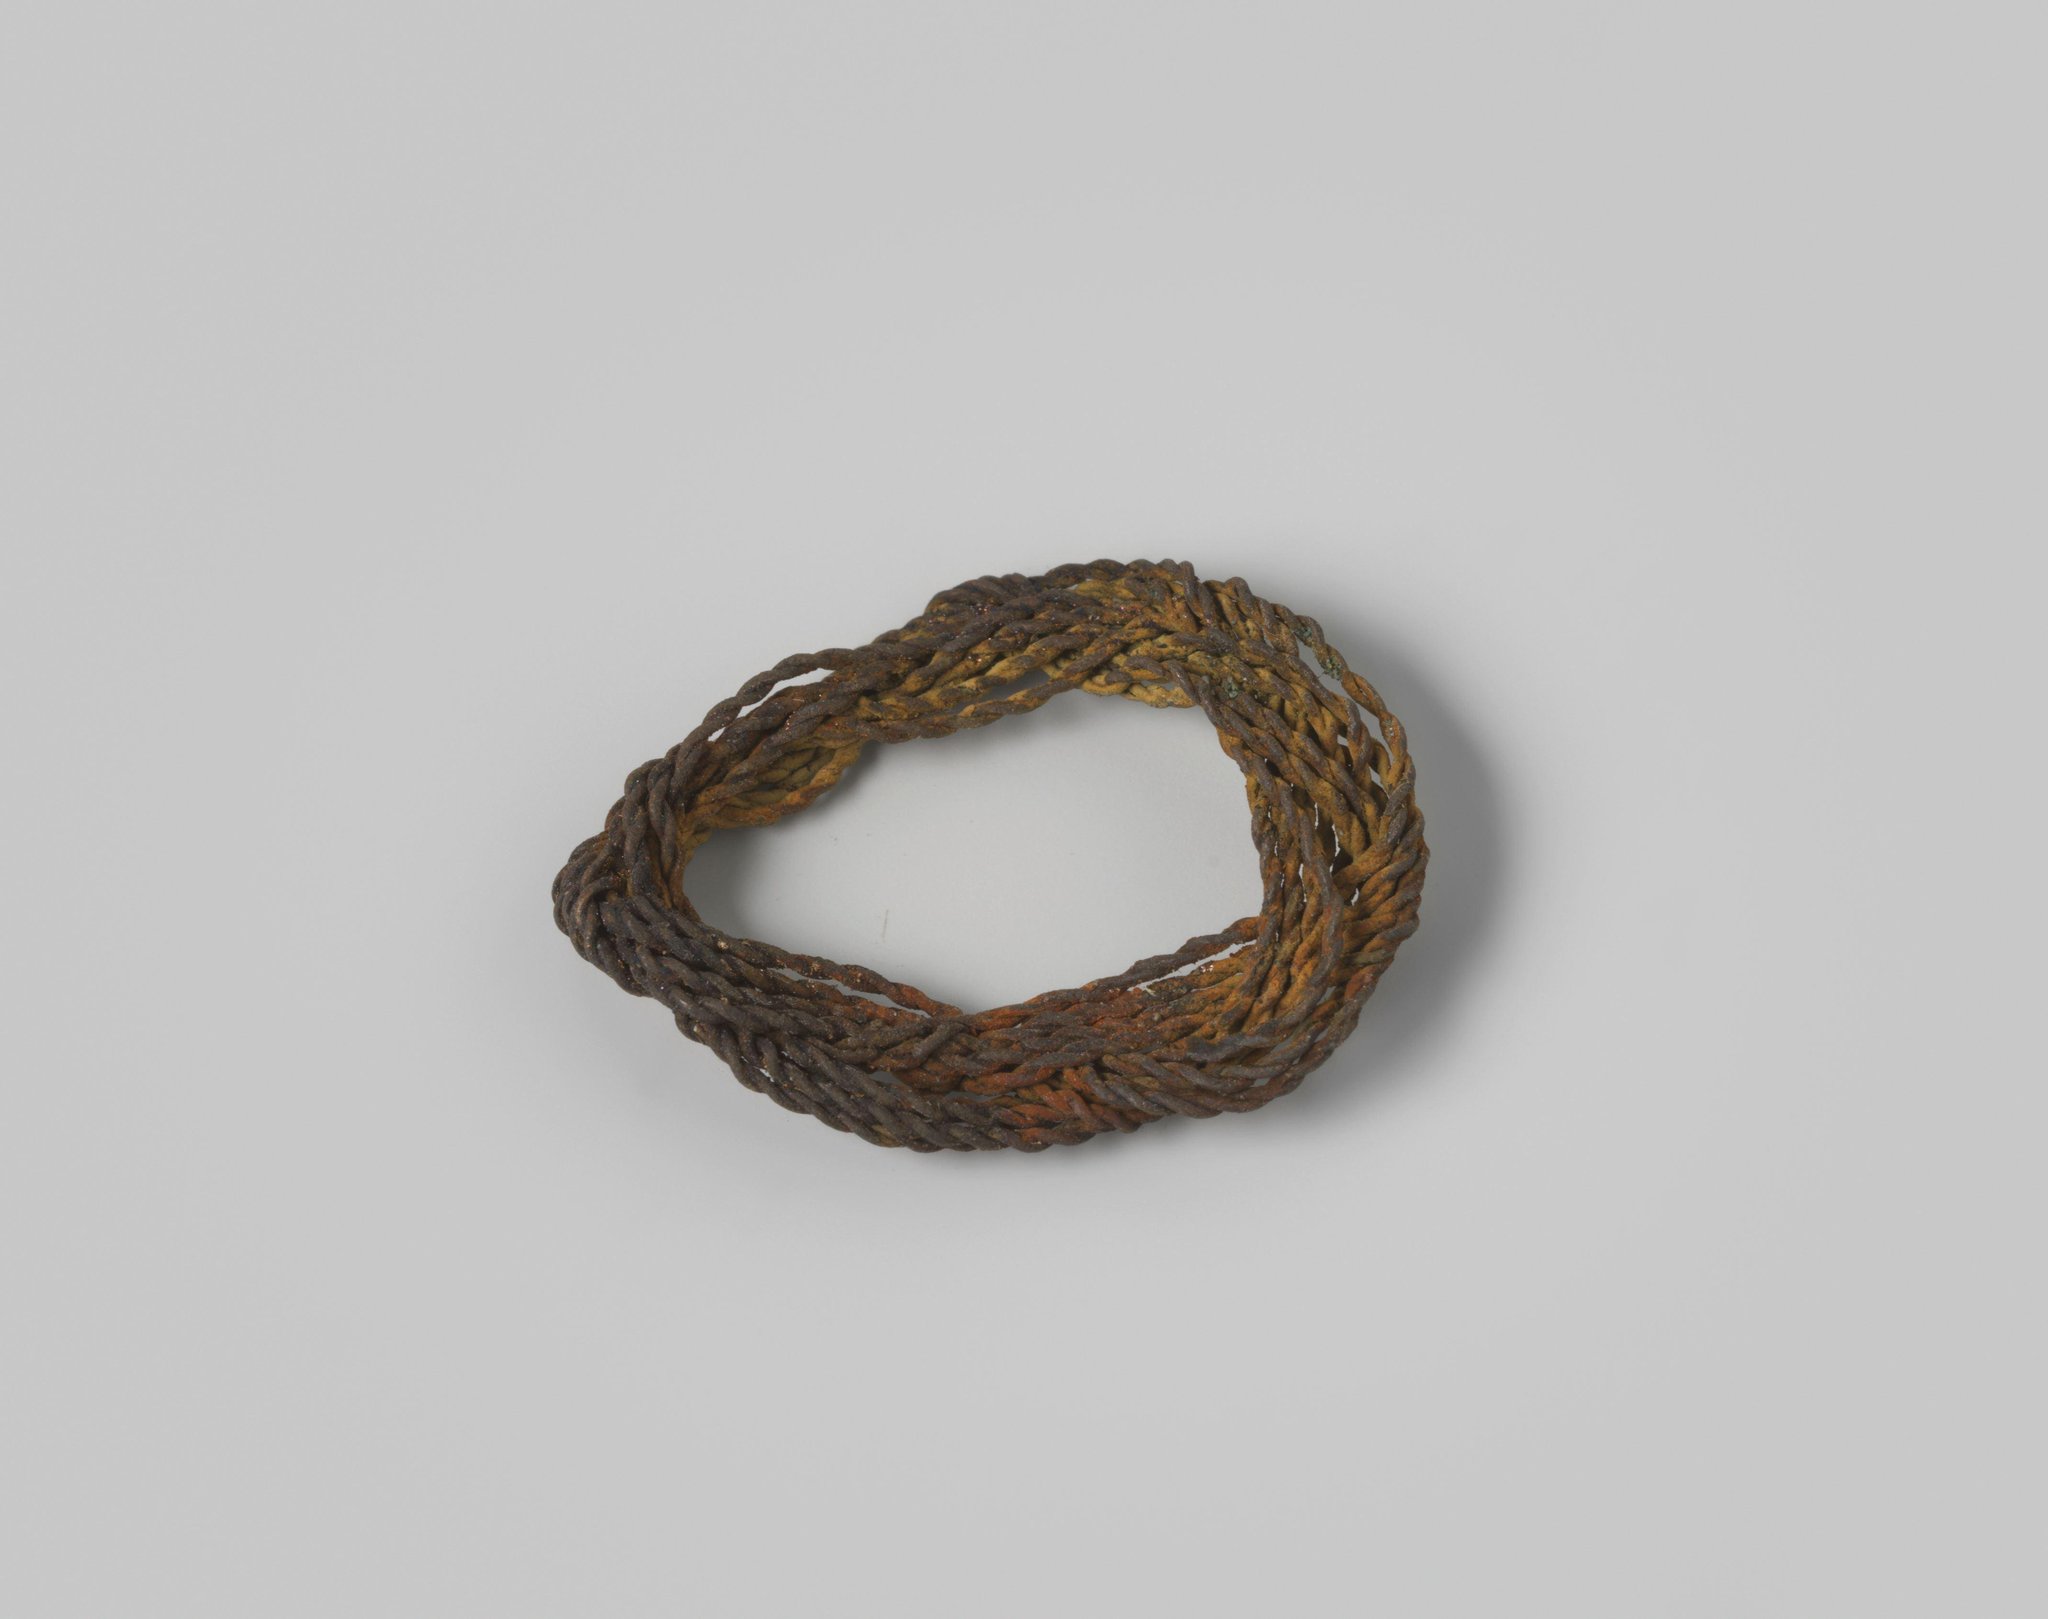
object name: ferrule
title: Beslagring van de greep van een gevest uit het wrak van de Oost-Indiëvaarder Hollandia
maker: Anonymous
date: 1700-1743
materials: copper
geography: netherlands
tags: verenigde oostindische compagnie, hollandia (schip), annet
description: Hilt, grip, ferrule; id. NG 1980-27H2582.